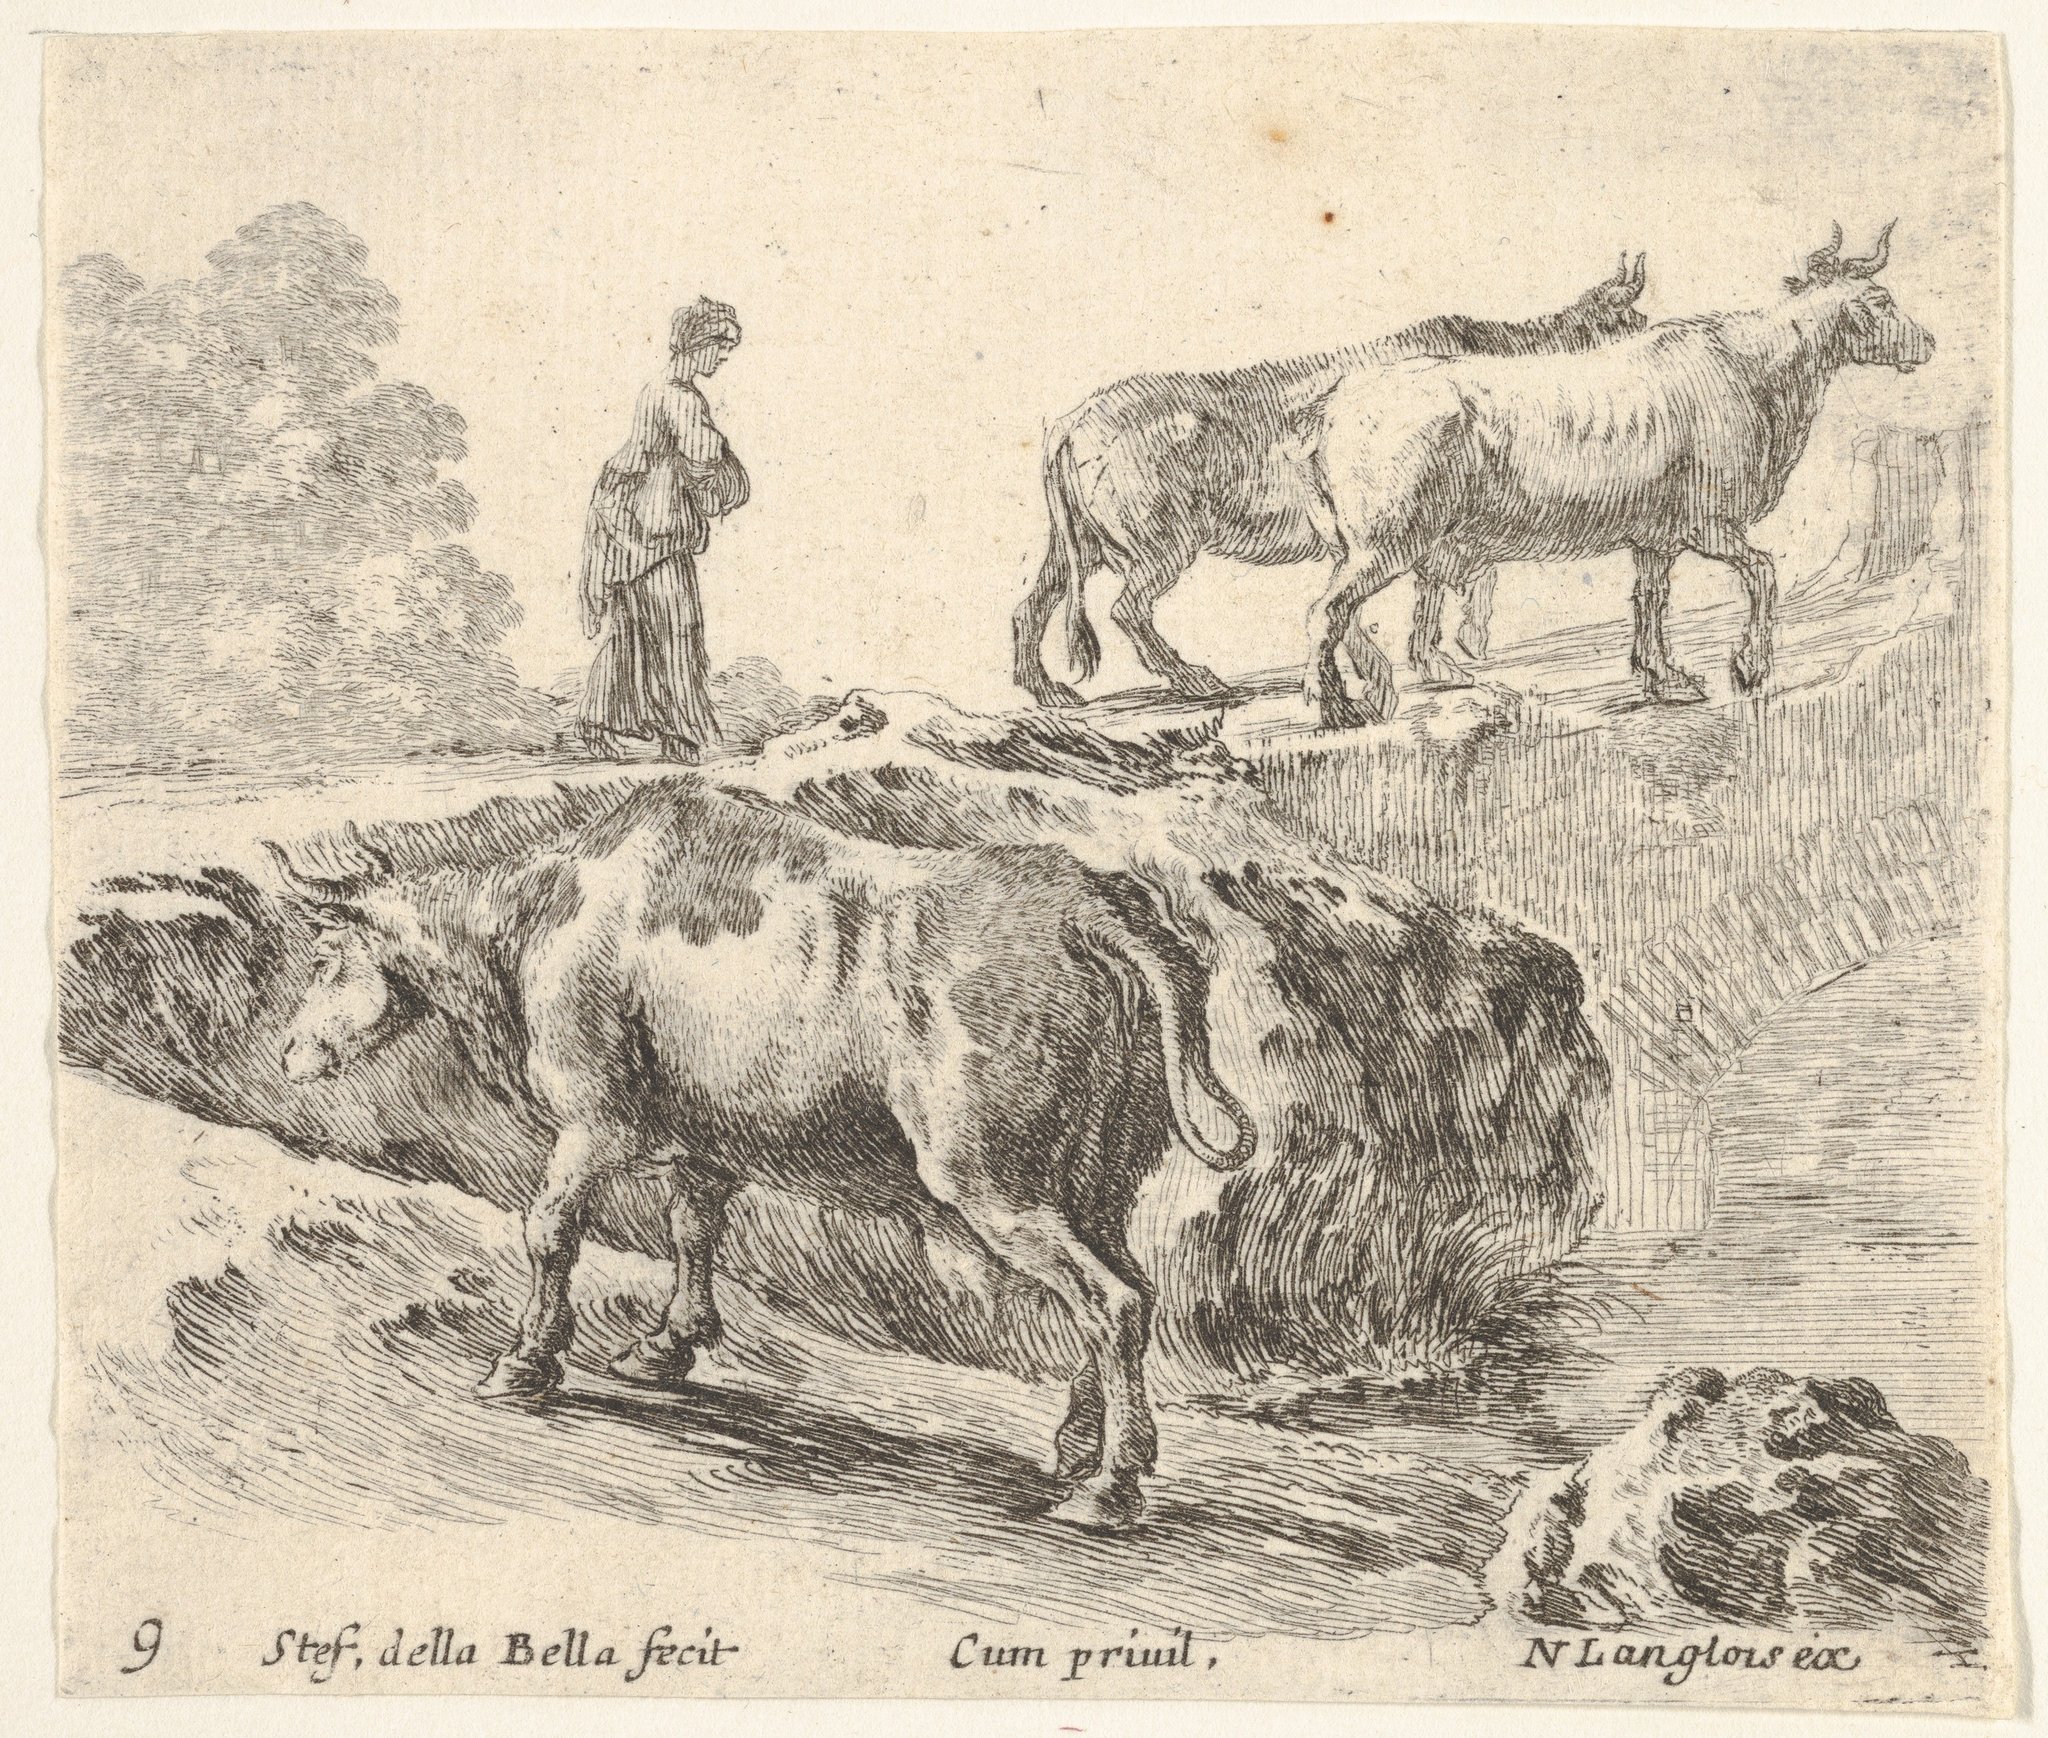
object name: print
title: Plate 9: a cow ascending a bank, a peasant woman leading two cows across a bridge in background, from "Diversi Capricci"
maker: stefano della bella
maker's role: artist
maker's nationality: italian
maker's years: 1610-1664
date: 1644-1647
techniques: etching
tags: bridges,women,cows